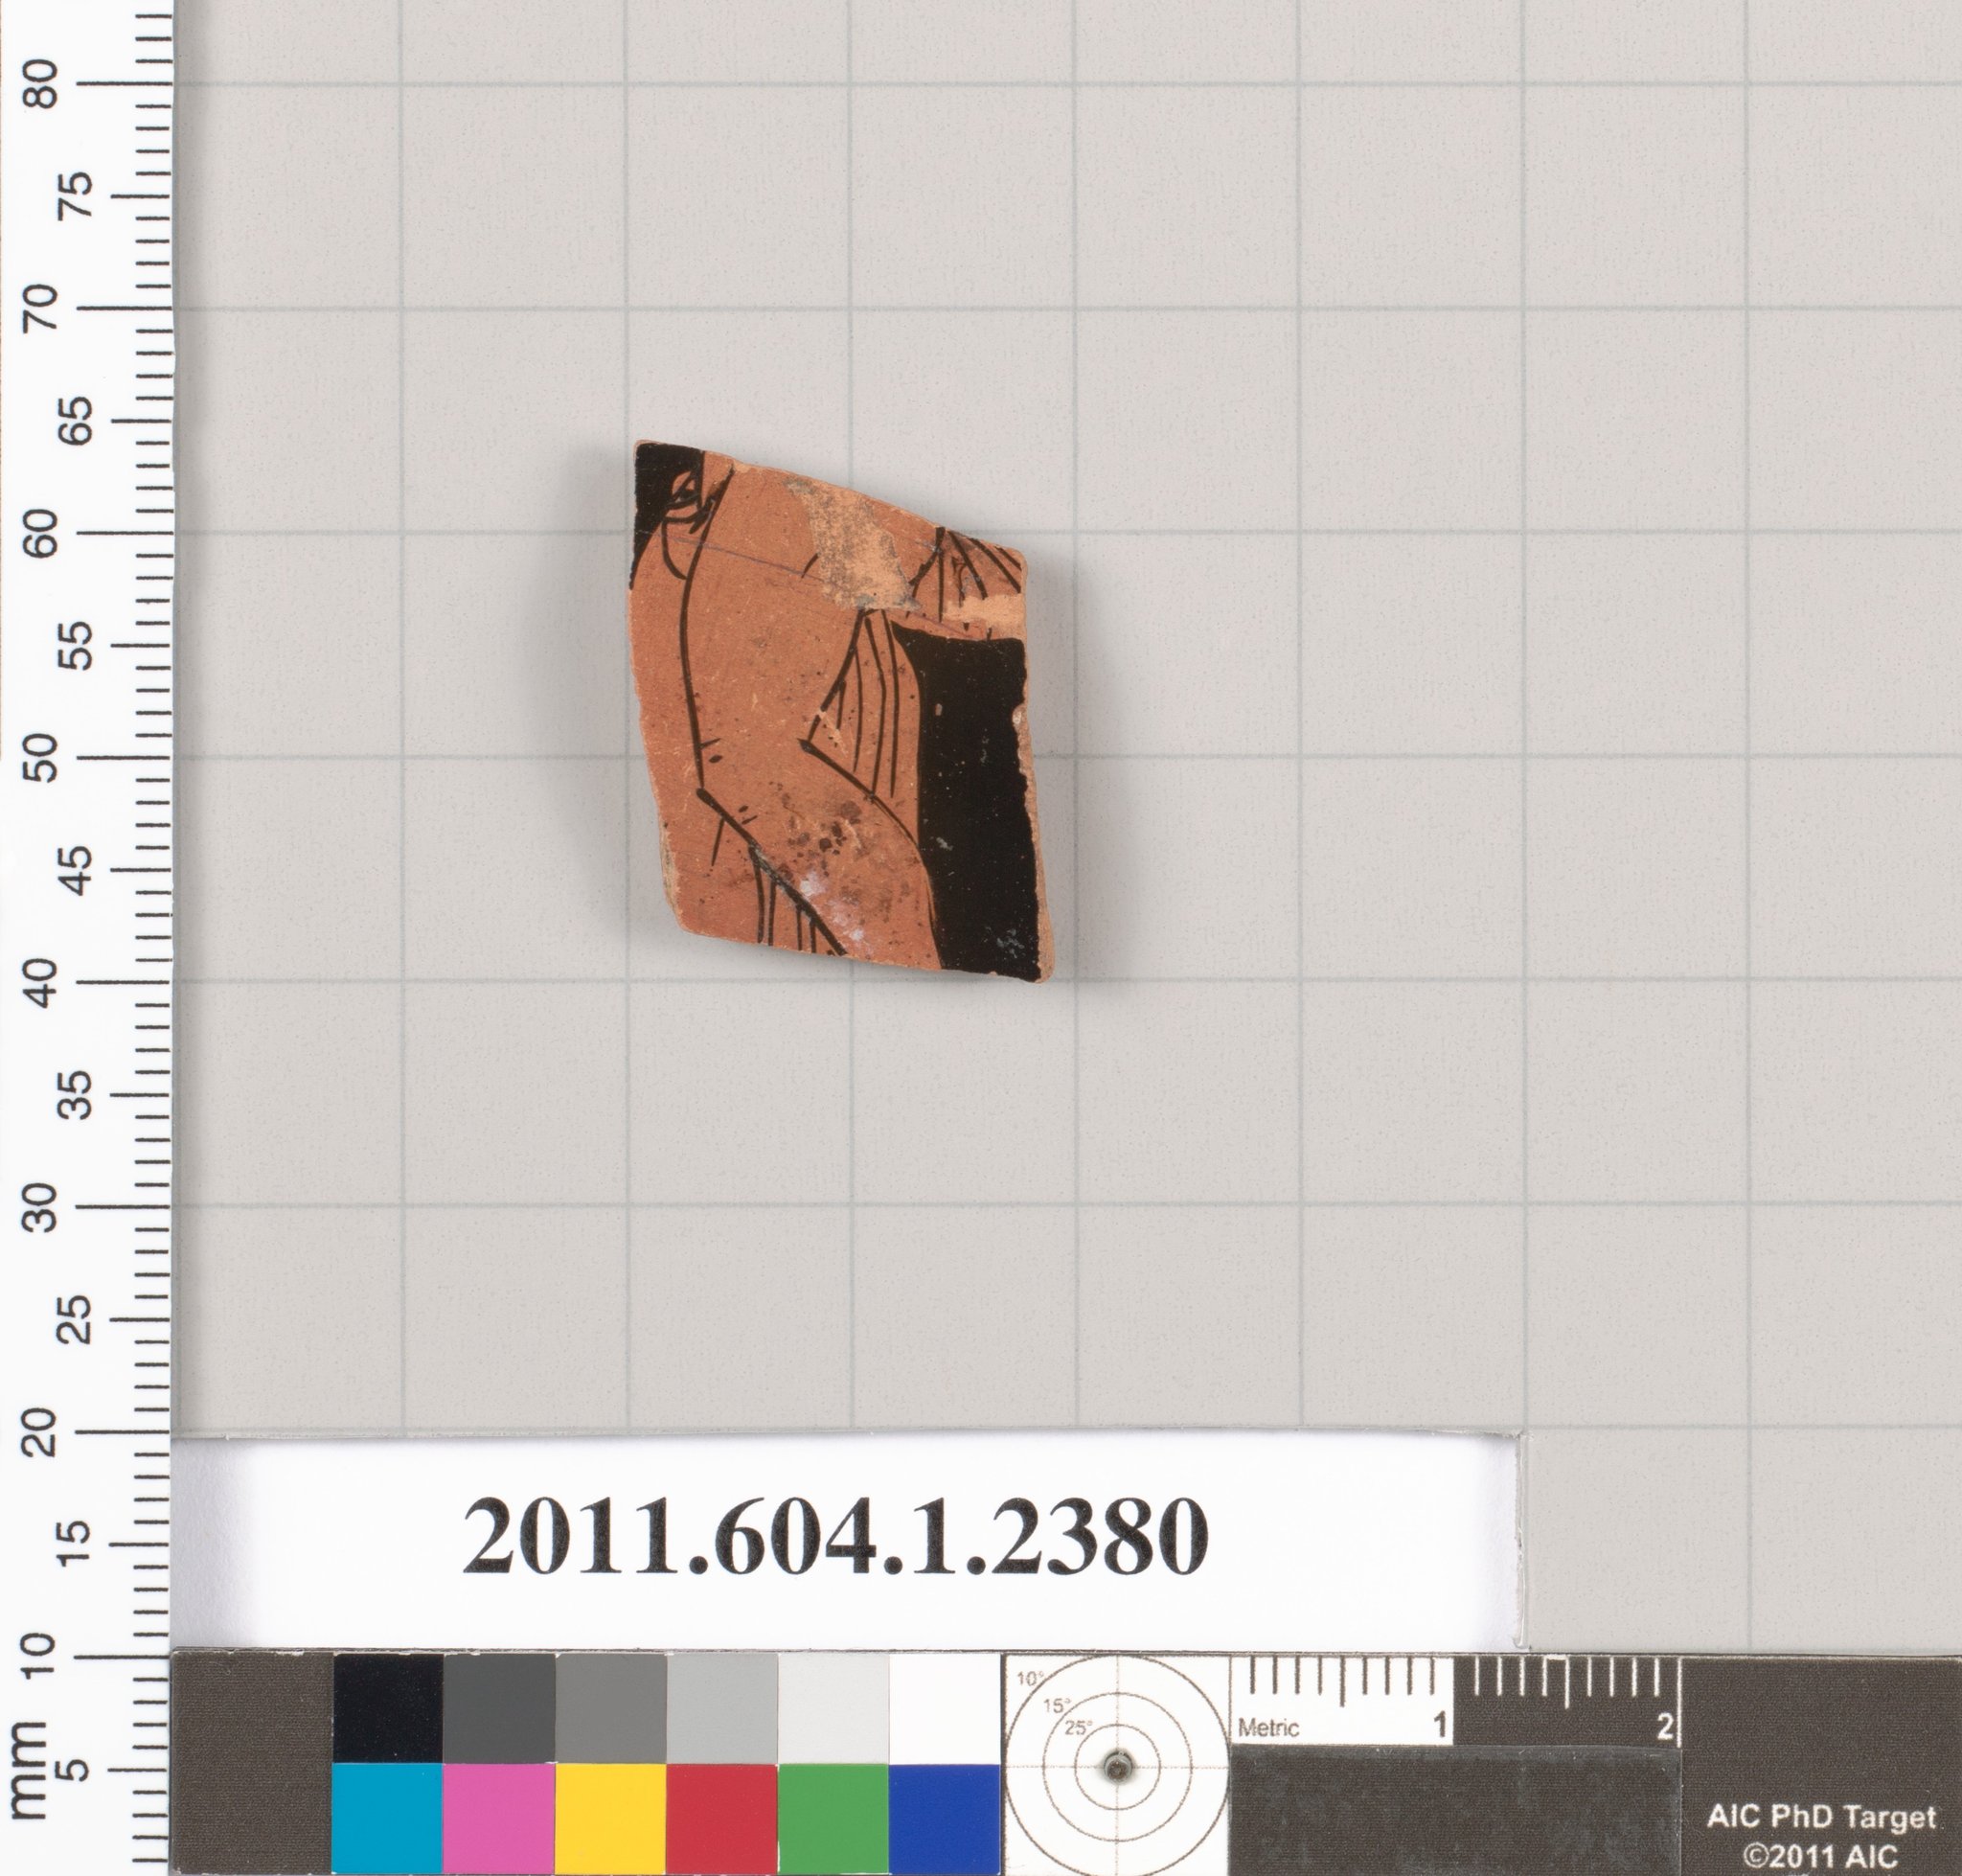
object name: kylix fragment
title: Terracotta fragment of a kylix (drinking cup)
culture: greek, attic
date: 475-451 BCE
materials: terracotta